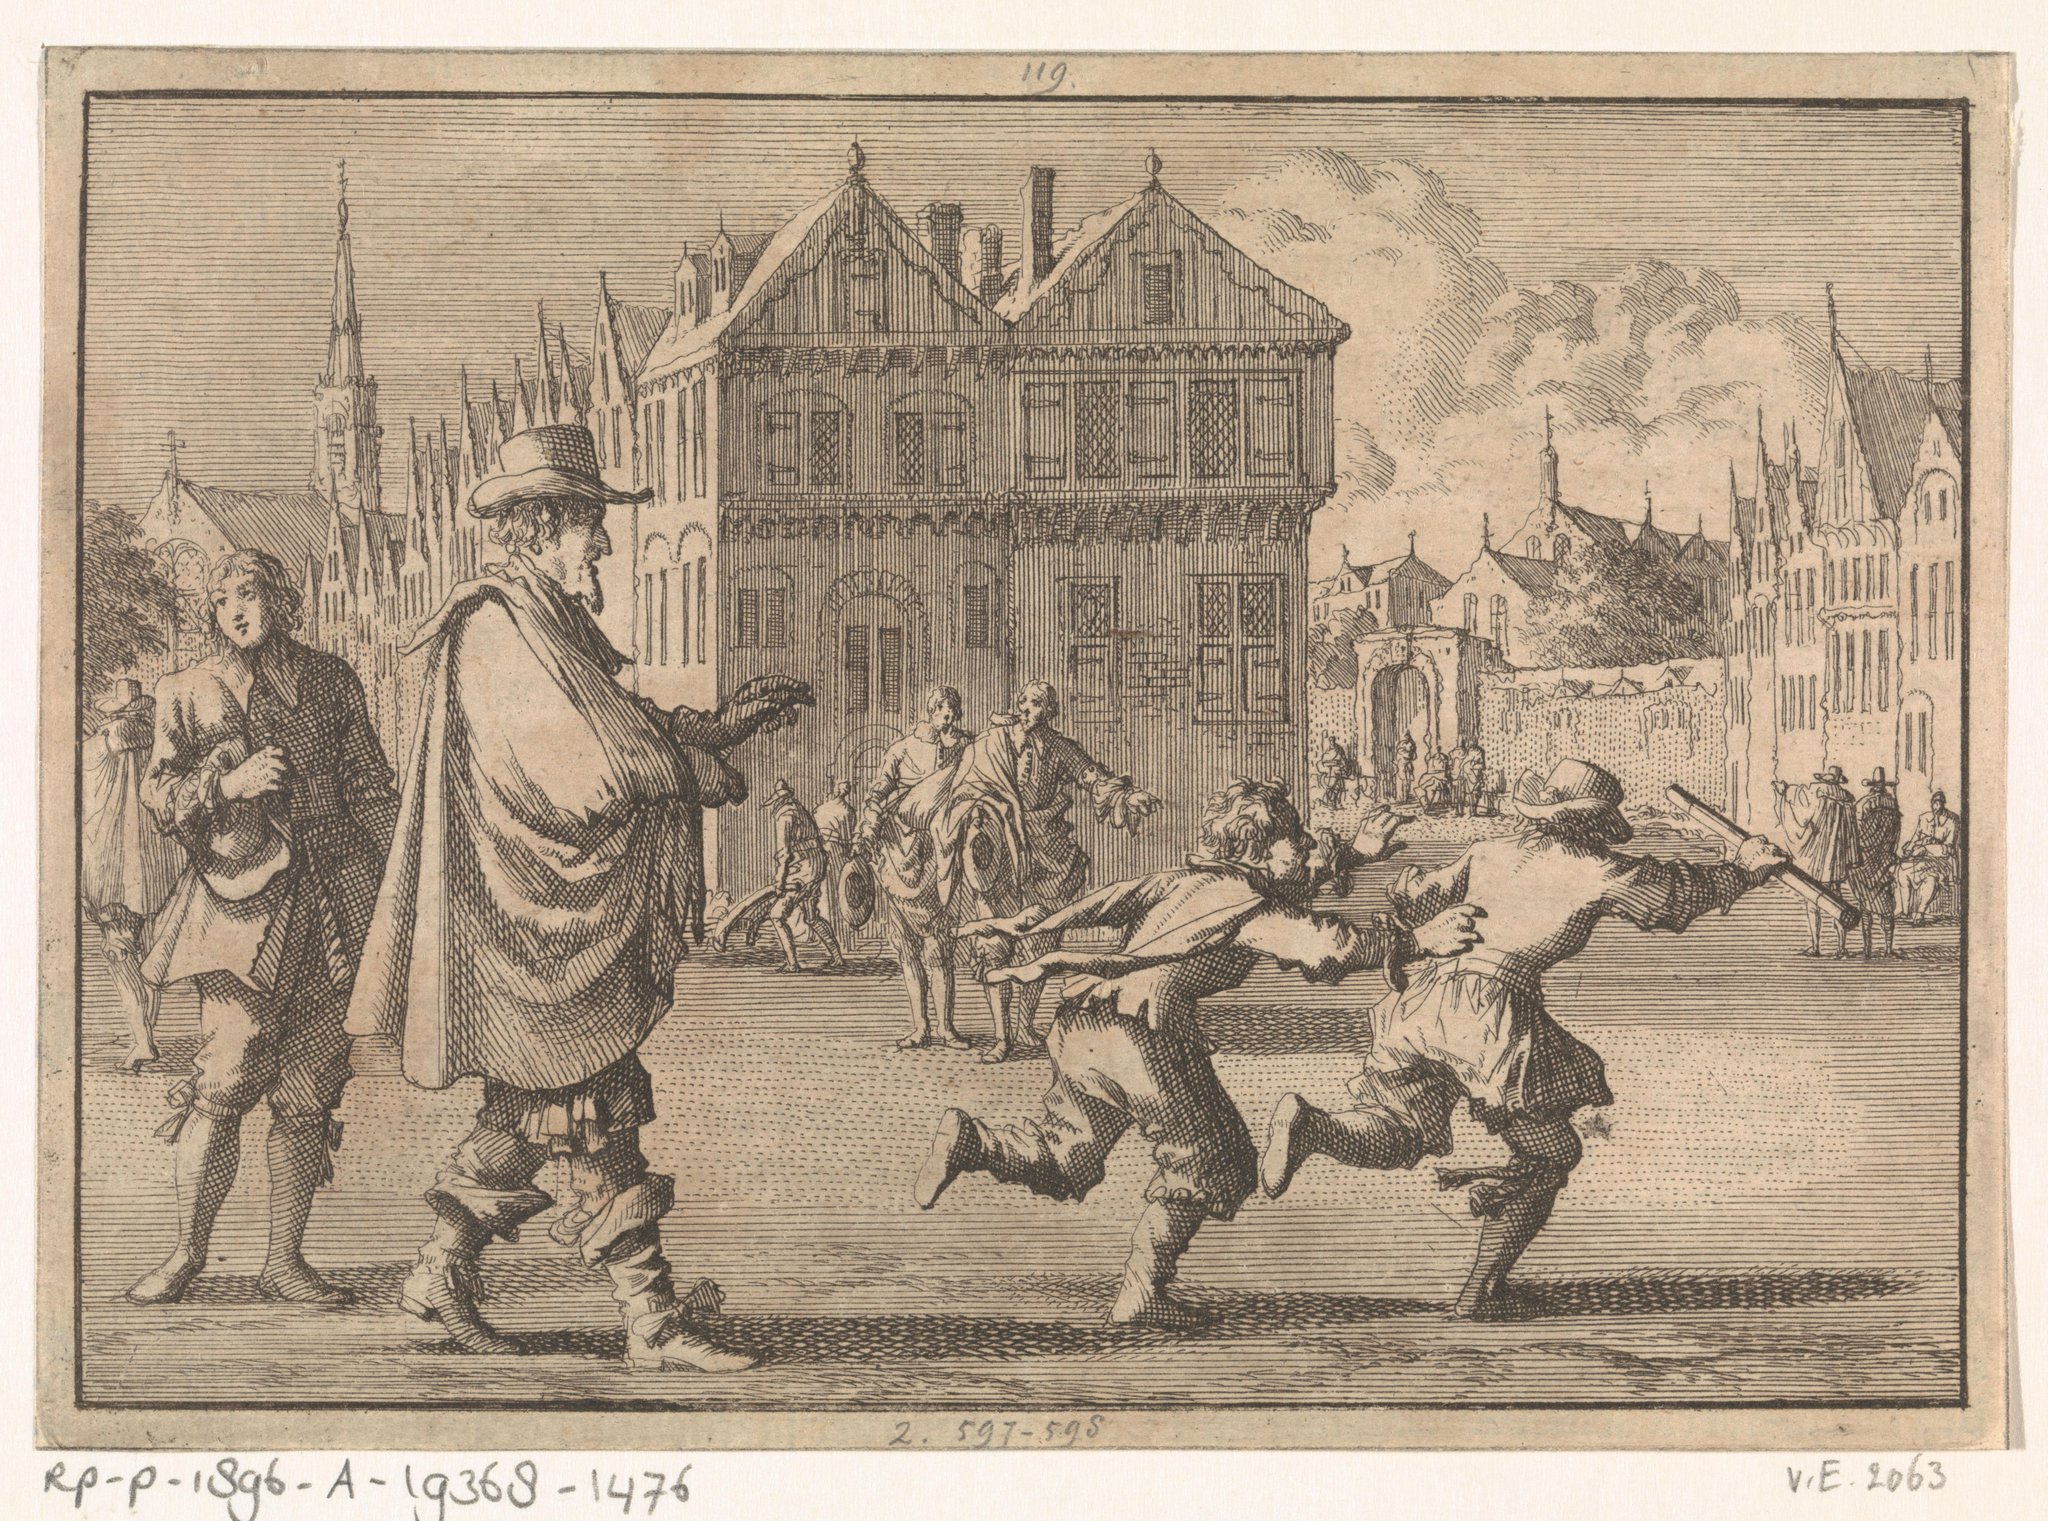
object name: print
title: Jongen beledigt de burgemeester van Straatsburg door de stok van diens bediende weg te rukken, 1671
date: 1698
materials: paper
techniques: etching, letterpress printing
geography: amsterdam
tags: mayor, burgomaster, mocking, insulting; teasing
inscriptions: collector's mark: Lugt 2228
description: Illustratie uit: Gottfried, Johann Ludwig. Historische kronyck; vervattende een (...) beschrijvingh der aldergedenckwaerdigste geschiedenissen des weerelds, van den aenvangh der scheppingh tot (...) 1576 (2 delen). Leiden: Pieter van der Aa, 1698, dl. II, p. 597.